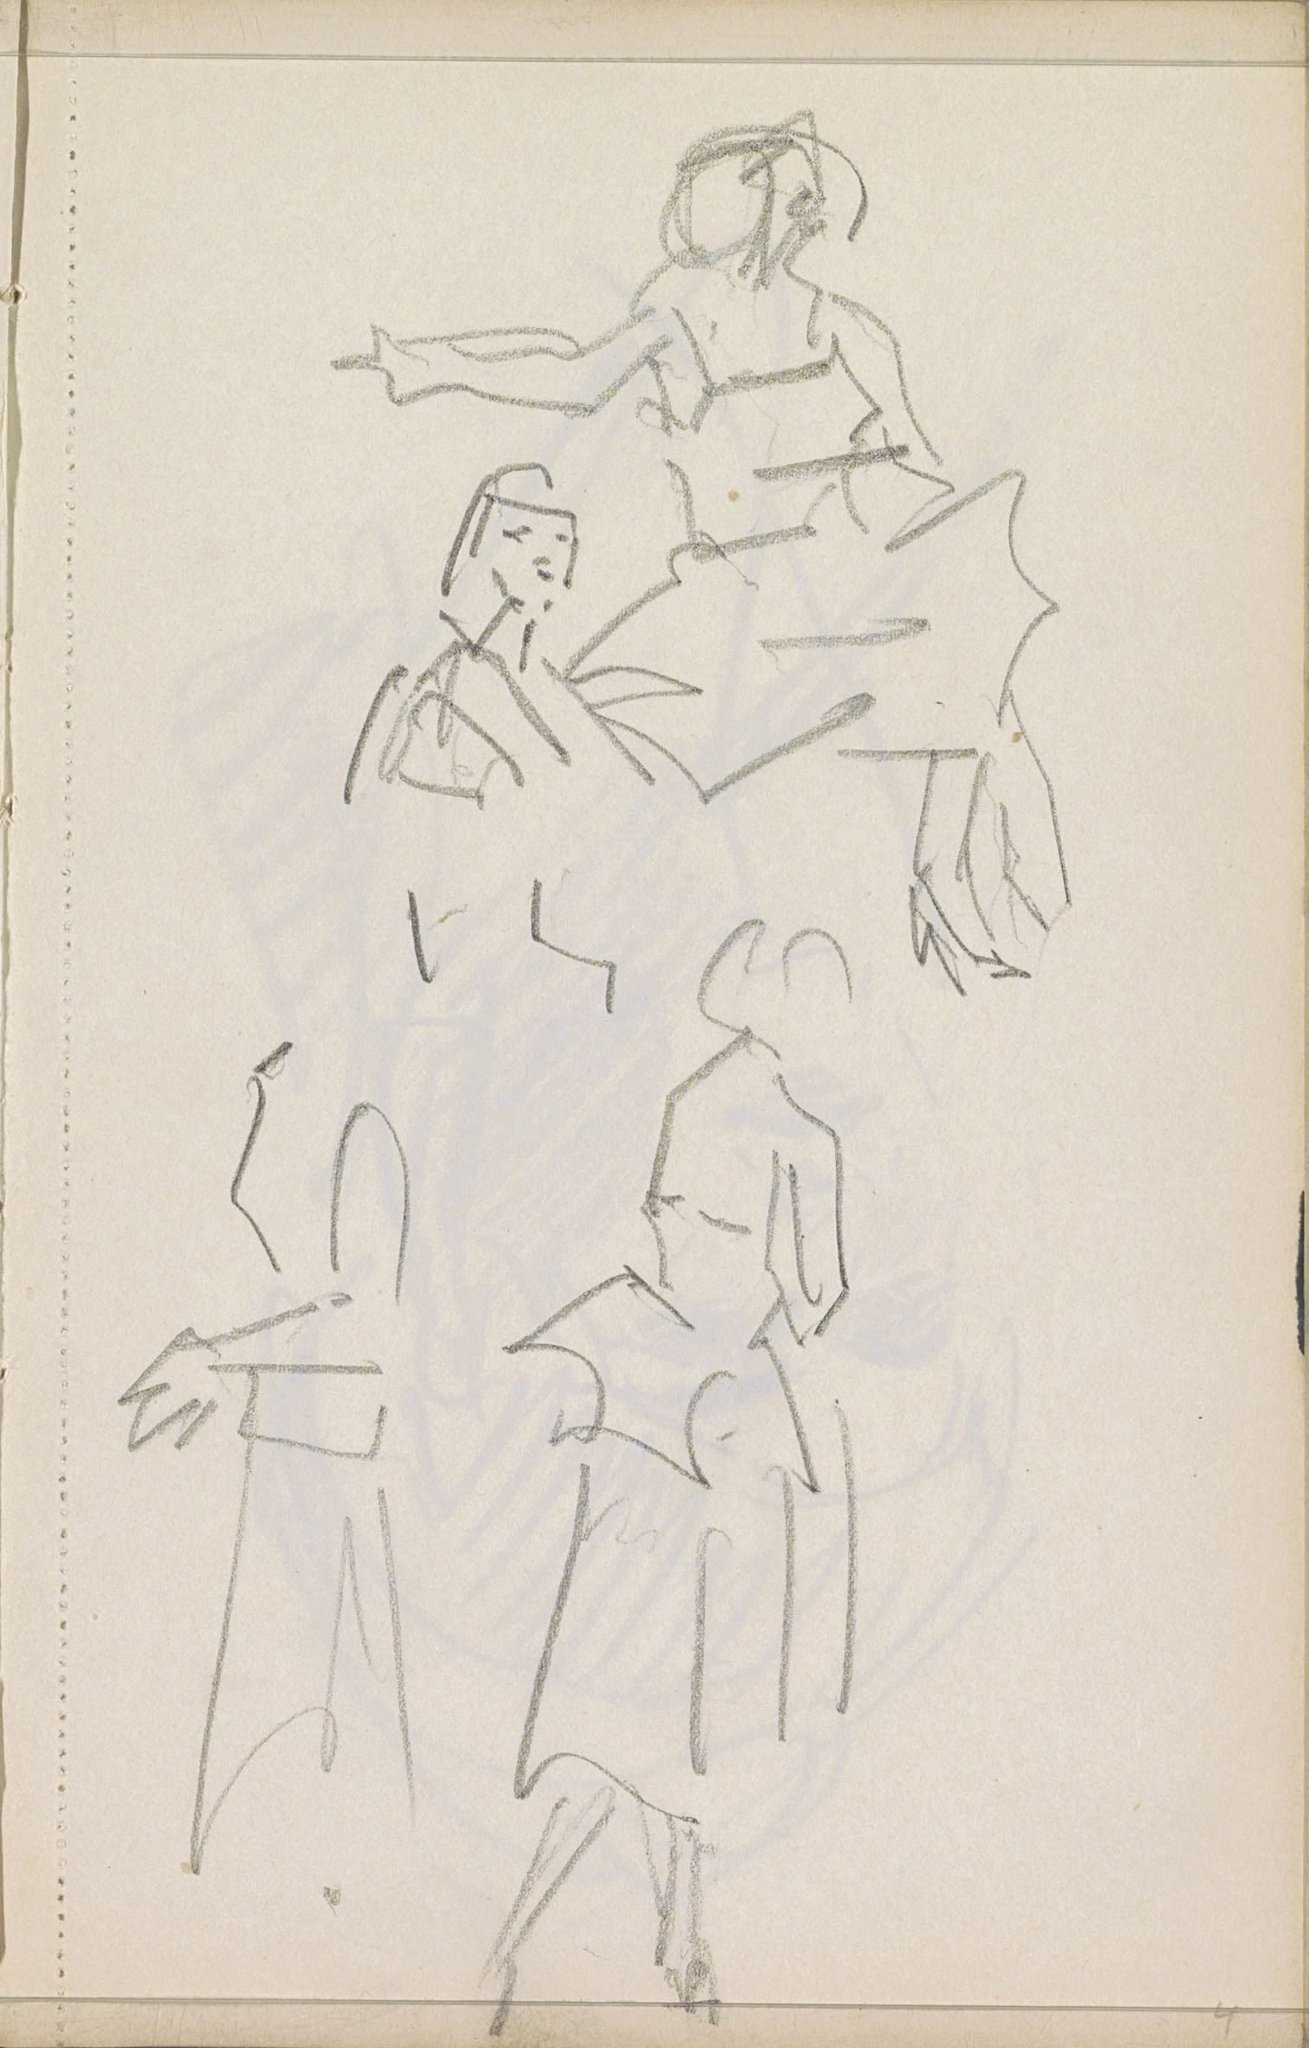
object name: sketchbook leaf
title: Vrouw in verschillende houdingen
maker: isaac israels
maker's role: draughtsman, painter, print maker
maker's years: 1865-1934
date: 1875-1934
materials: paper, pencil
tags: adult woman (+ standing), the (nude) human figure; 'corpo humano' (ripa) - aa - female human figure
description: Blad 4 recto uit schetsboek LII met 43 bladen.